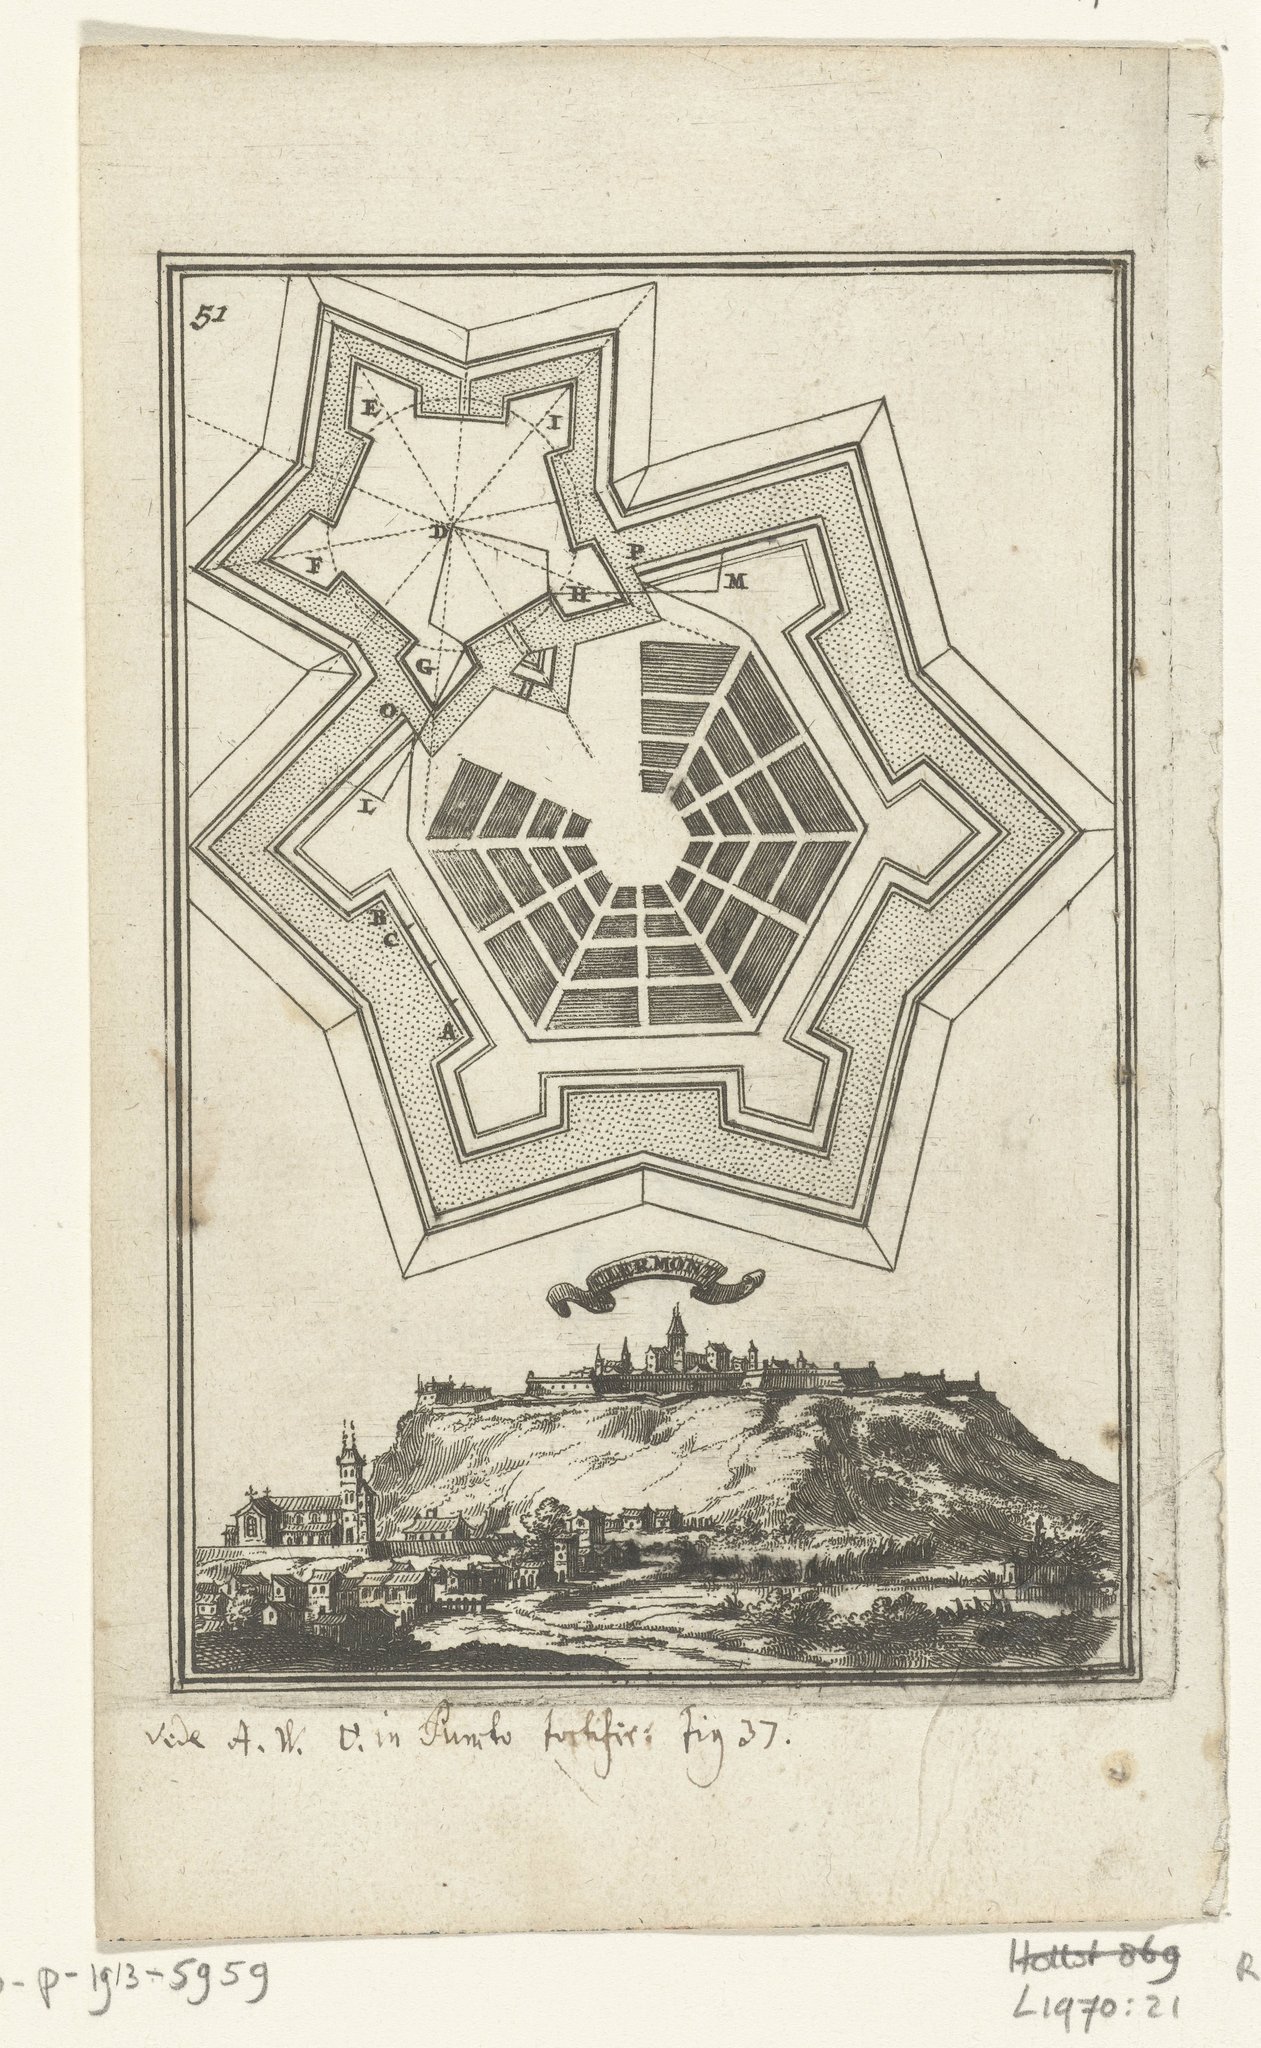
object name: print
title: Illustratie voor 'Den Arbeid van Mars' van Allain Manesson Mallet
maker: romeyn de hooghe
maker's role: draughtsman, goldsmith, painter, print maker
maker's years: 1645-1708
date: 1672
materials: paper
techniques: etching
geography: amsterdam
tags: fortifications, military engineering, prospect of city, town panorama, silhouette of city, mathematics, mountains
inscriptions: inscription: ‘Vide A.W. V. [?] in Punito [?] fortific: Fig 37.’, collector's mark: Lugt 2228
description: Grondplan voor een vesting, fort of versterking. Daaronder een gezicht op een vesting op een berg ('Clermont' = Clermont-Ferrand?). In de hoek linksboven het cijfer 51 (= het nummer van de pagina in het boek waartegenover de illustratie geplaatst is).